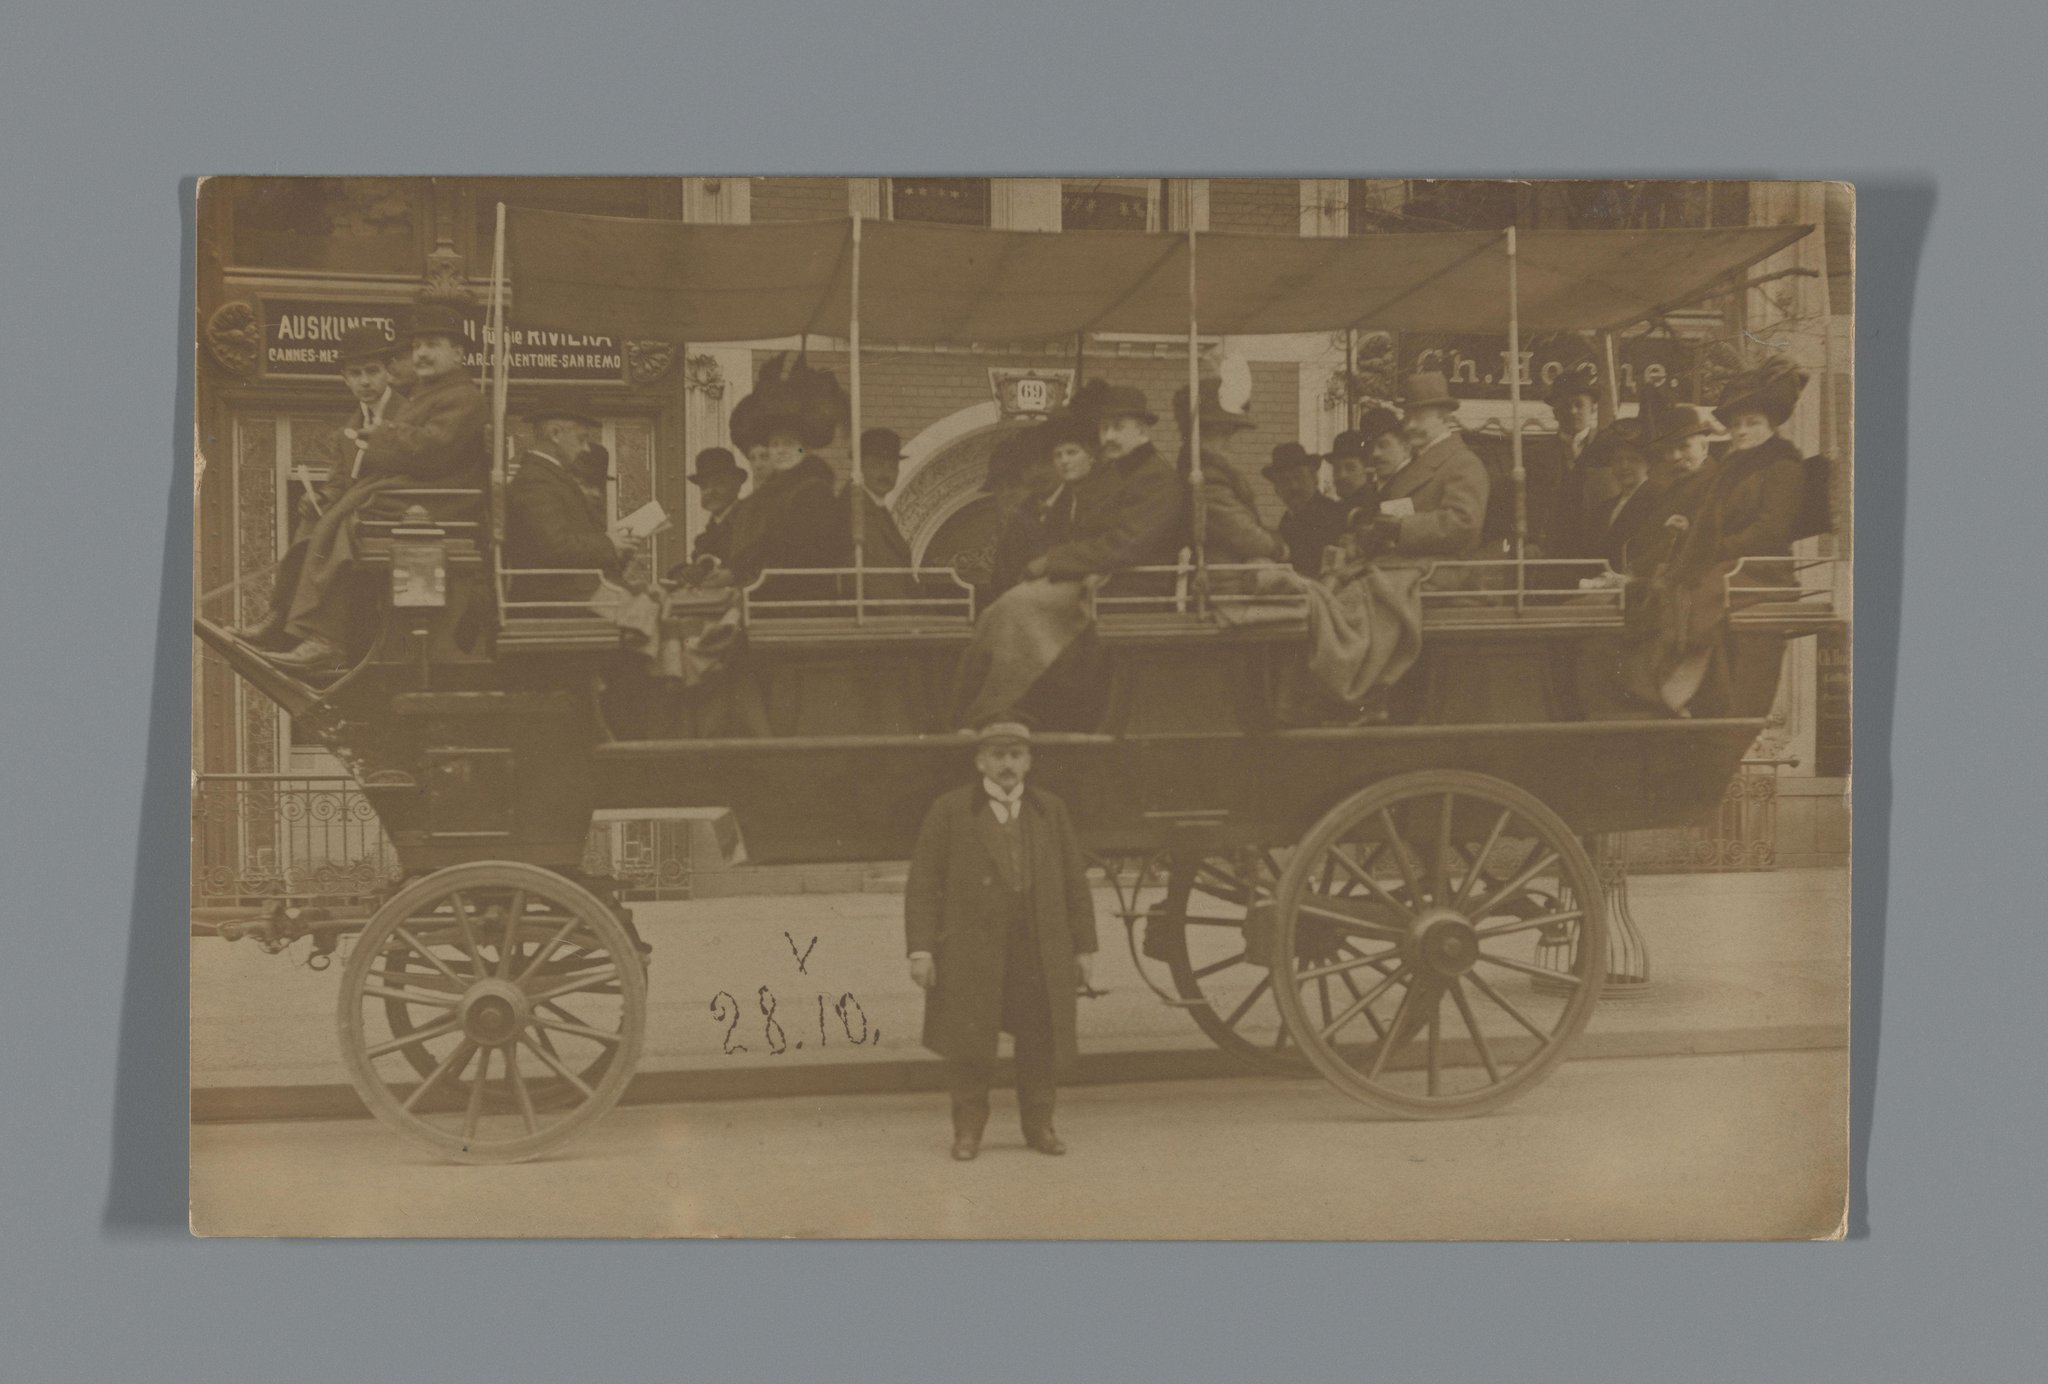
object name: photomechanical print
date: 1910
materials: cardboard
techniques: autotype